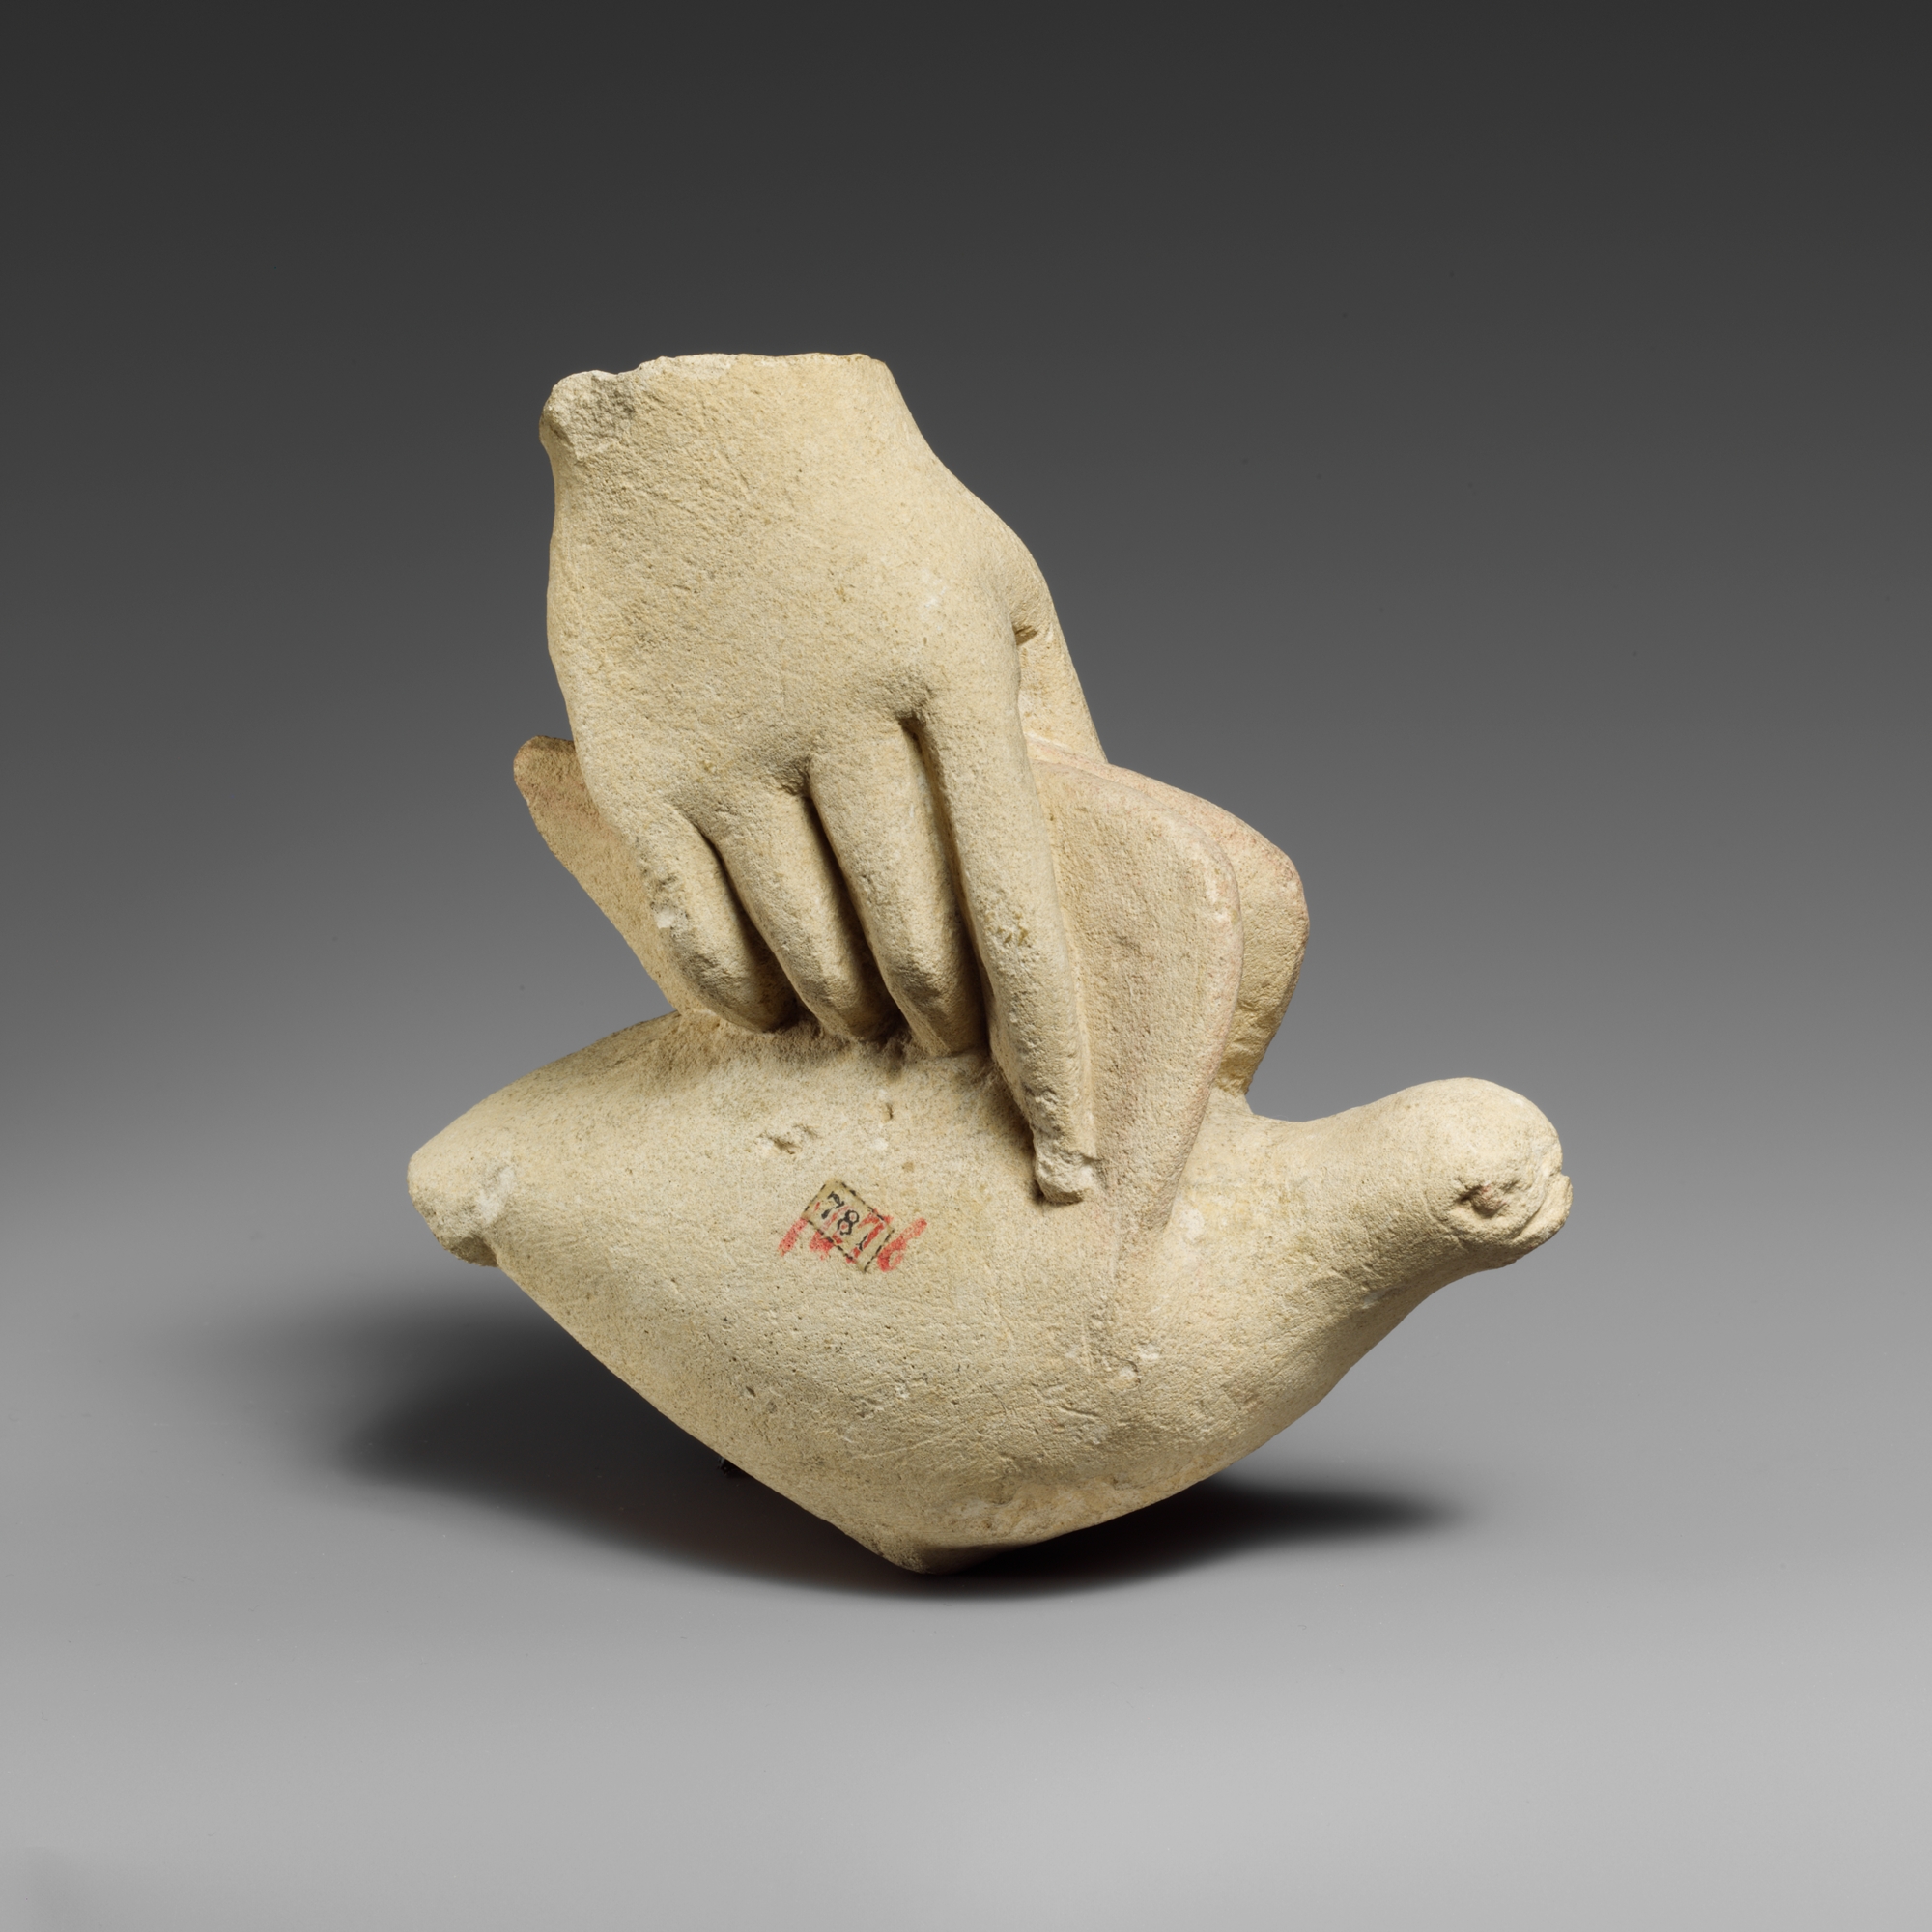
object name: hand, right, holding dove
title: Limestone hand holding a dove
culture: cypriot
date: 3900 BCE-100 CE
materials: limestone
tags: doves,hands